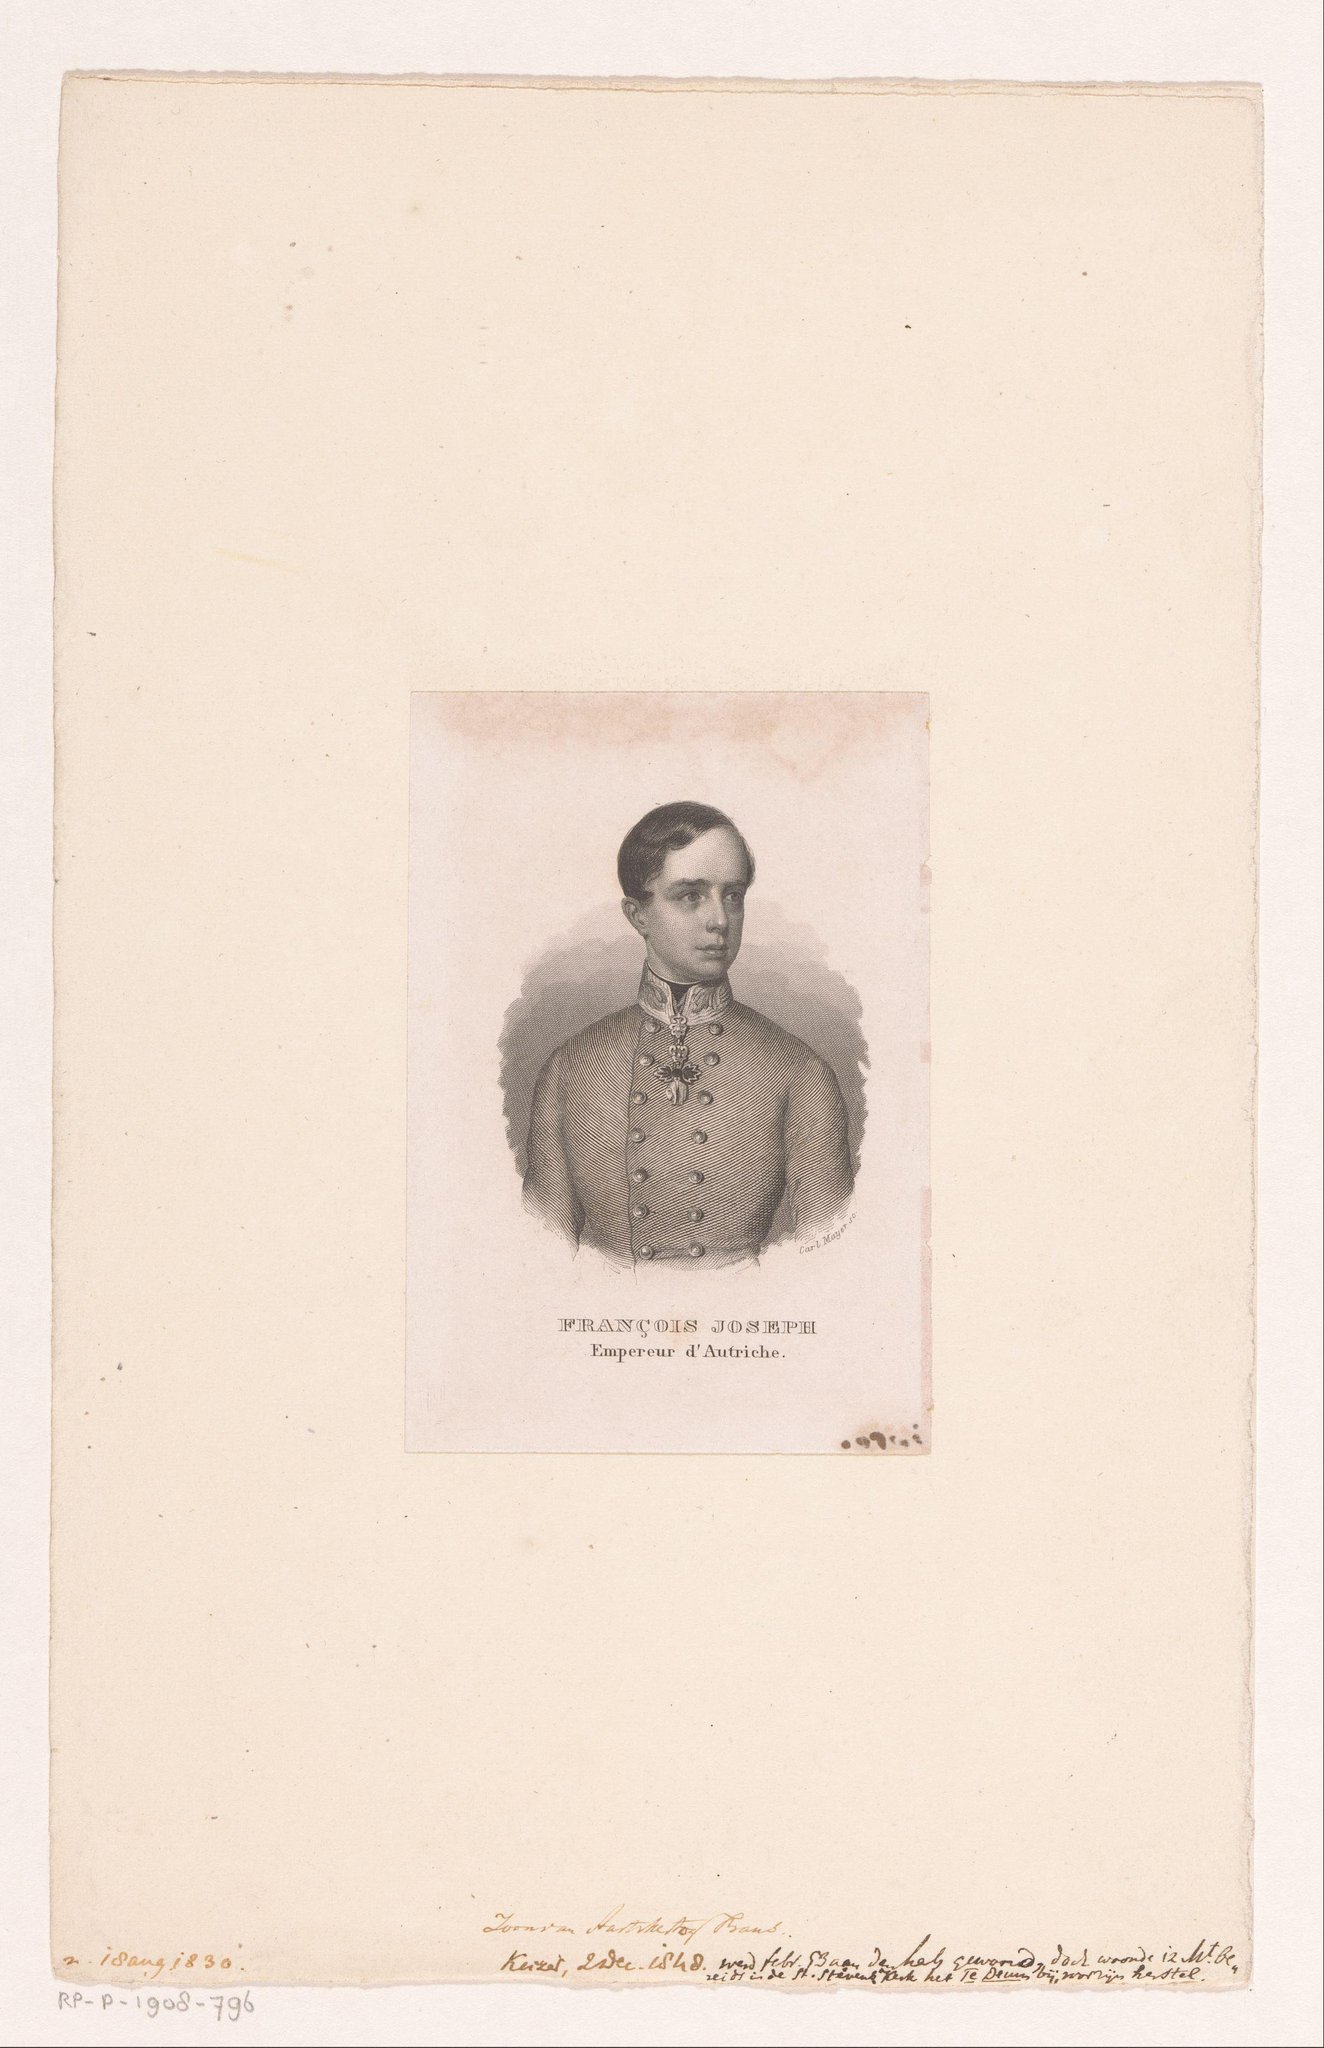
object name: print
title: Portret van Frans Jozef I van Oostenrijk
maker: carl mayer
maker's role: print maker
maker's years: 1798-1868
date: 1830-1868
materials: paper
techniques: engraving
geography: nuremberg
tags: vienna, historical persons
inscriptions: collector's mark: Lugt 2228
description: Vermoedelijk afkomstig uit: Almanach de Gotha.